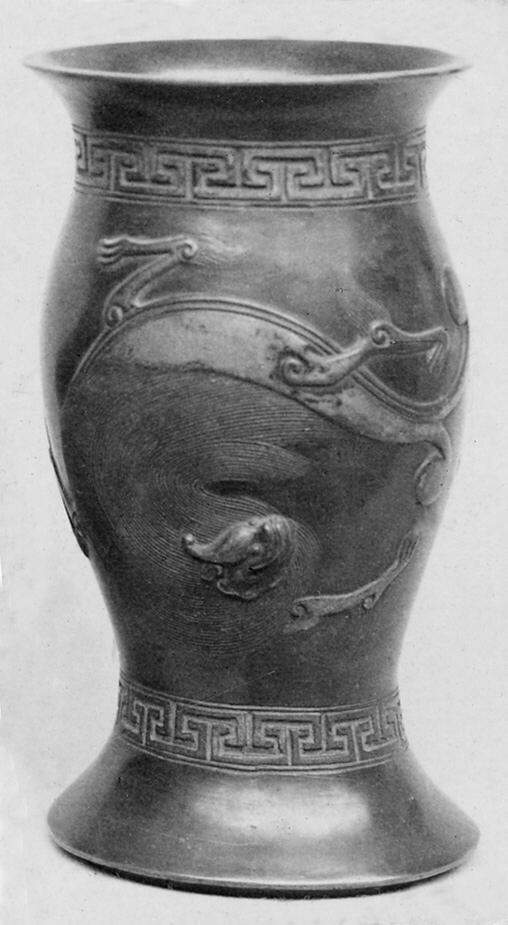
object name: vase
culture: japanese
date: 1801-1900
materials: bronze, silver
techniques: inlay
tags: mythical creatures